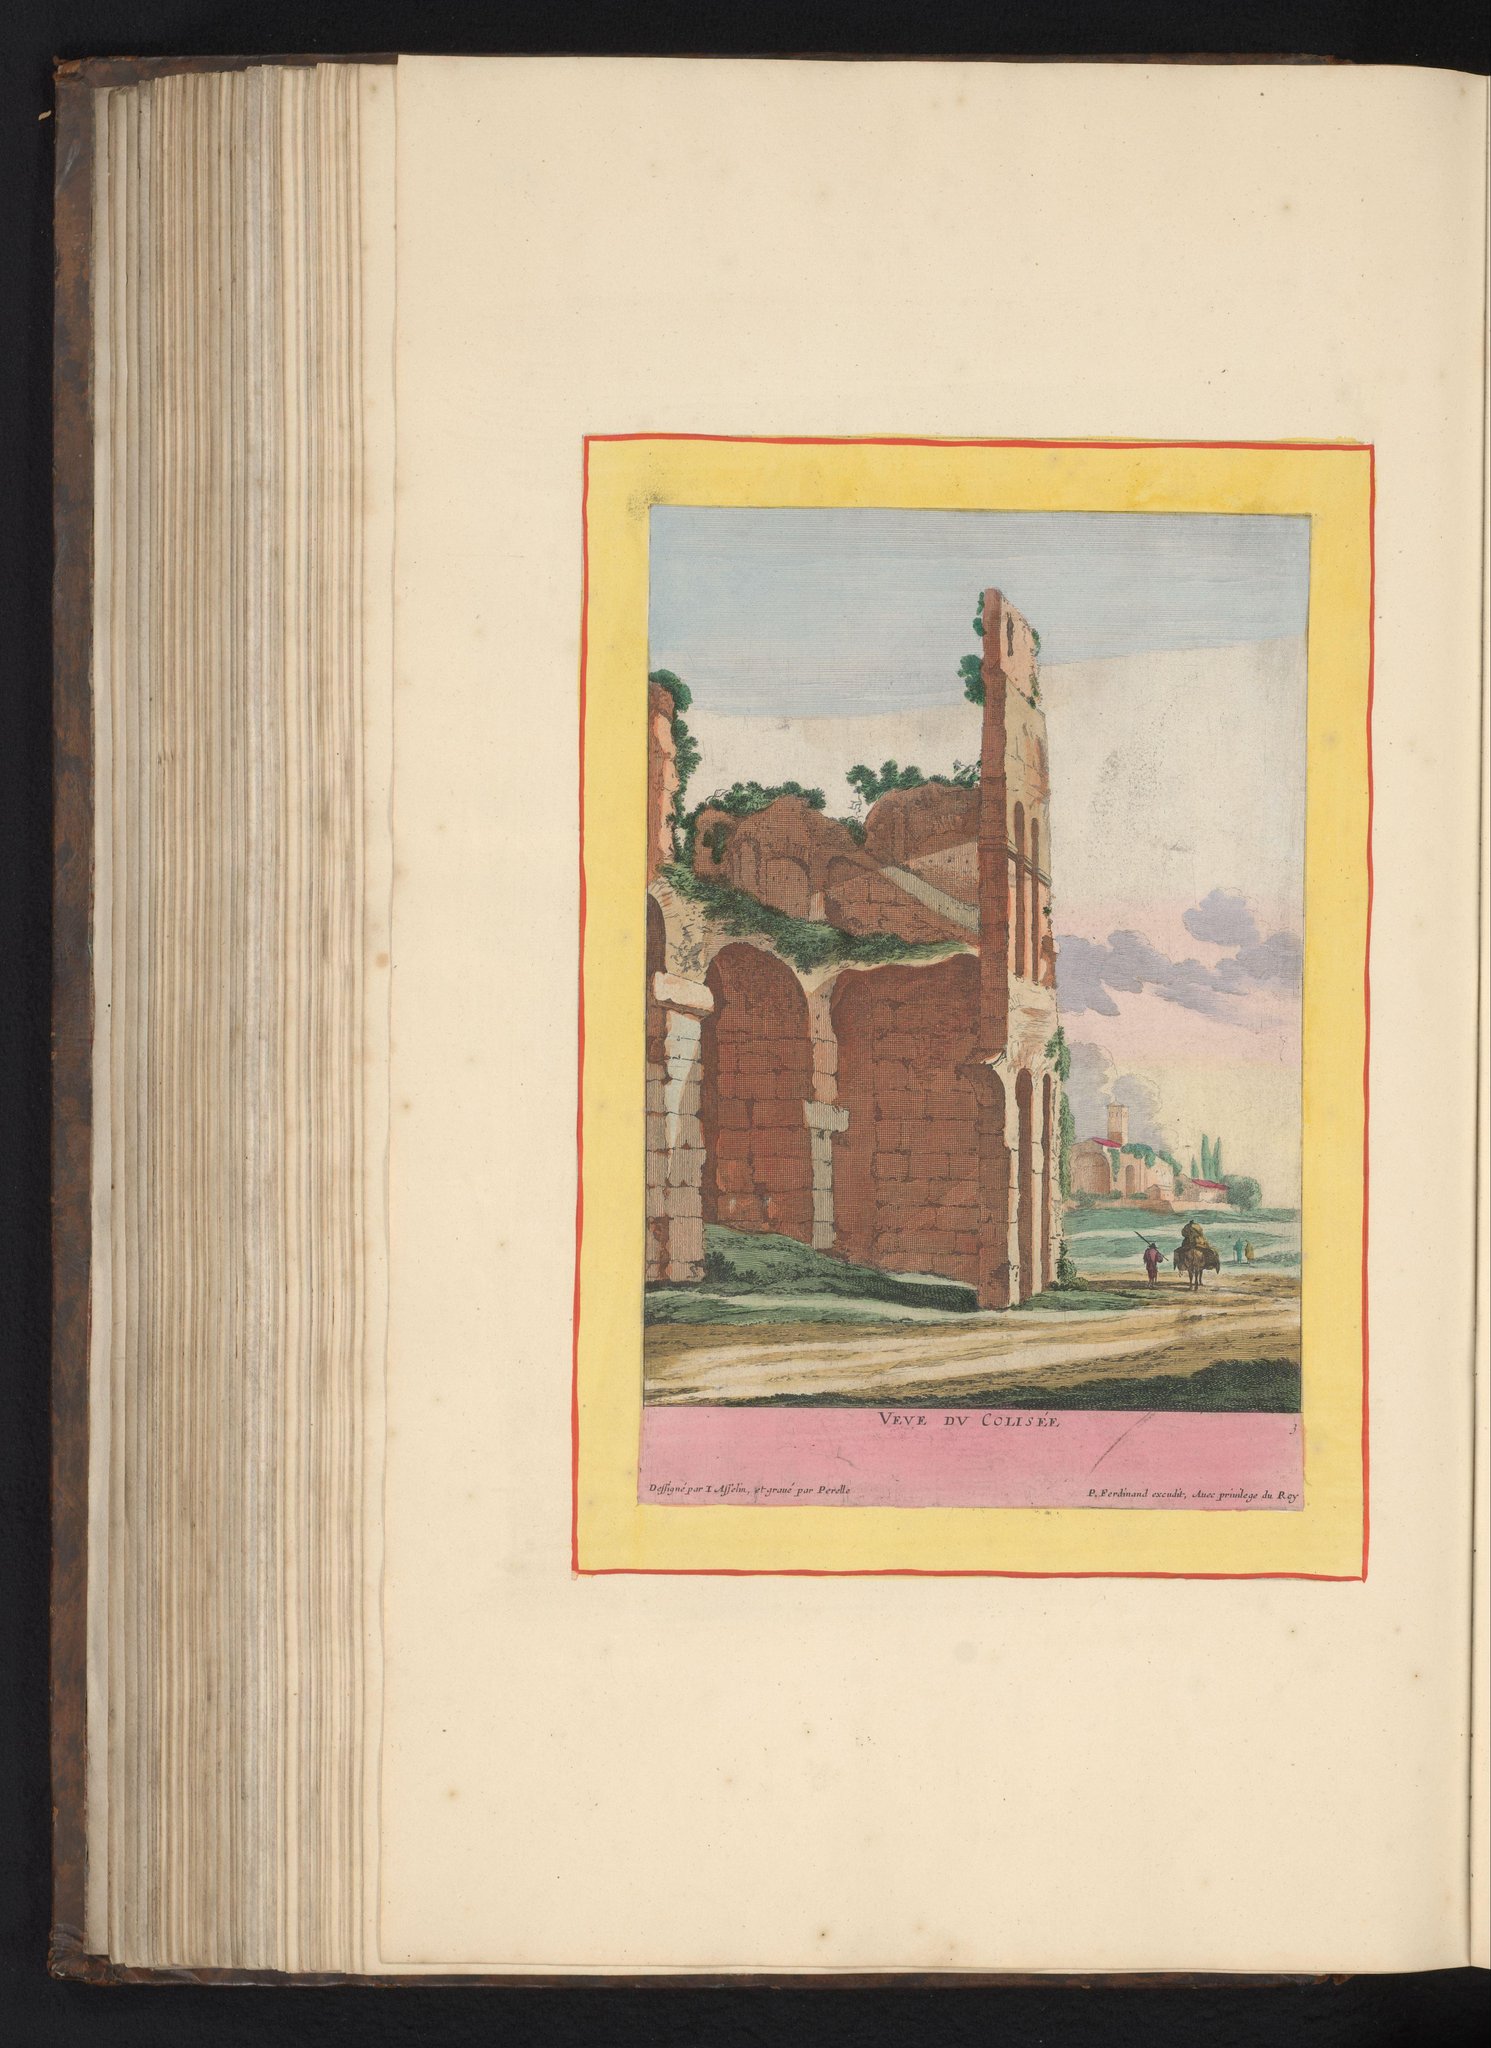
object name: print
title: Veue du Colisée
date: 1627-1655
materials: paper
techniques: colour, etching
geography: france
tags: ruin of a building ~ architecture, landscape with ruins, theatre (building) - aa - open-air performances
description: Landschap met de resten van een Romeins amfitheater. Rechts een lopende man en een vrouw op een ezel. Titel in ondermarge. Prent maakt deel uit van een album.